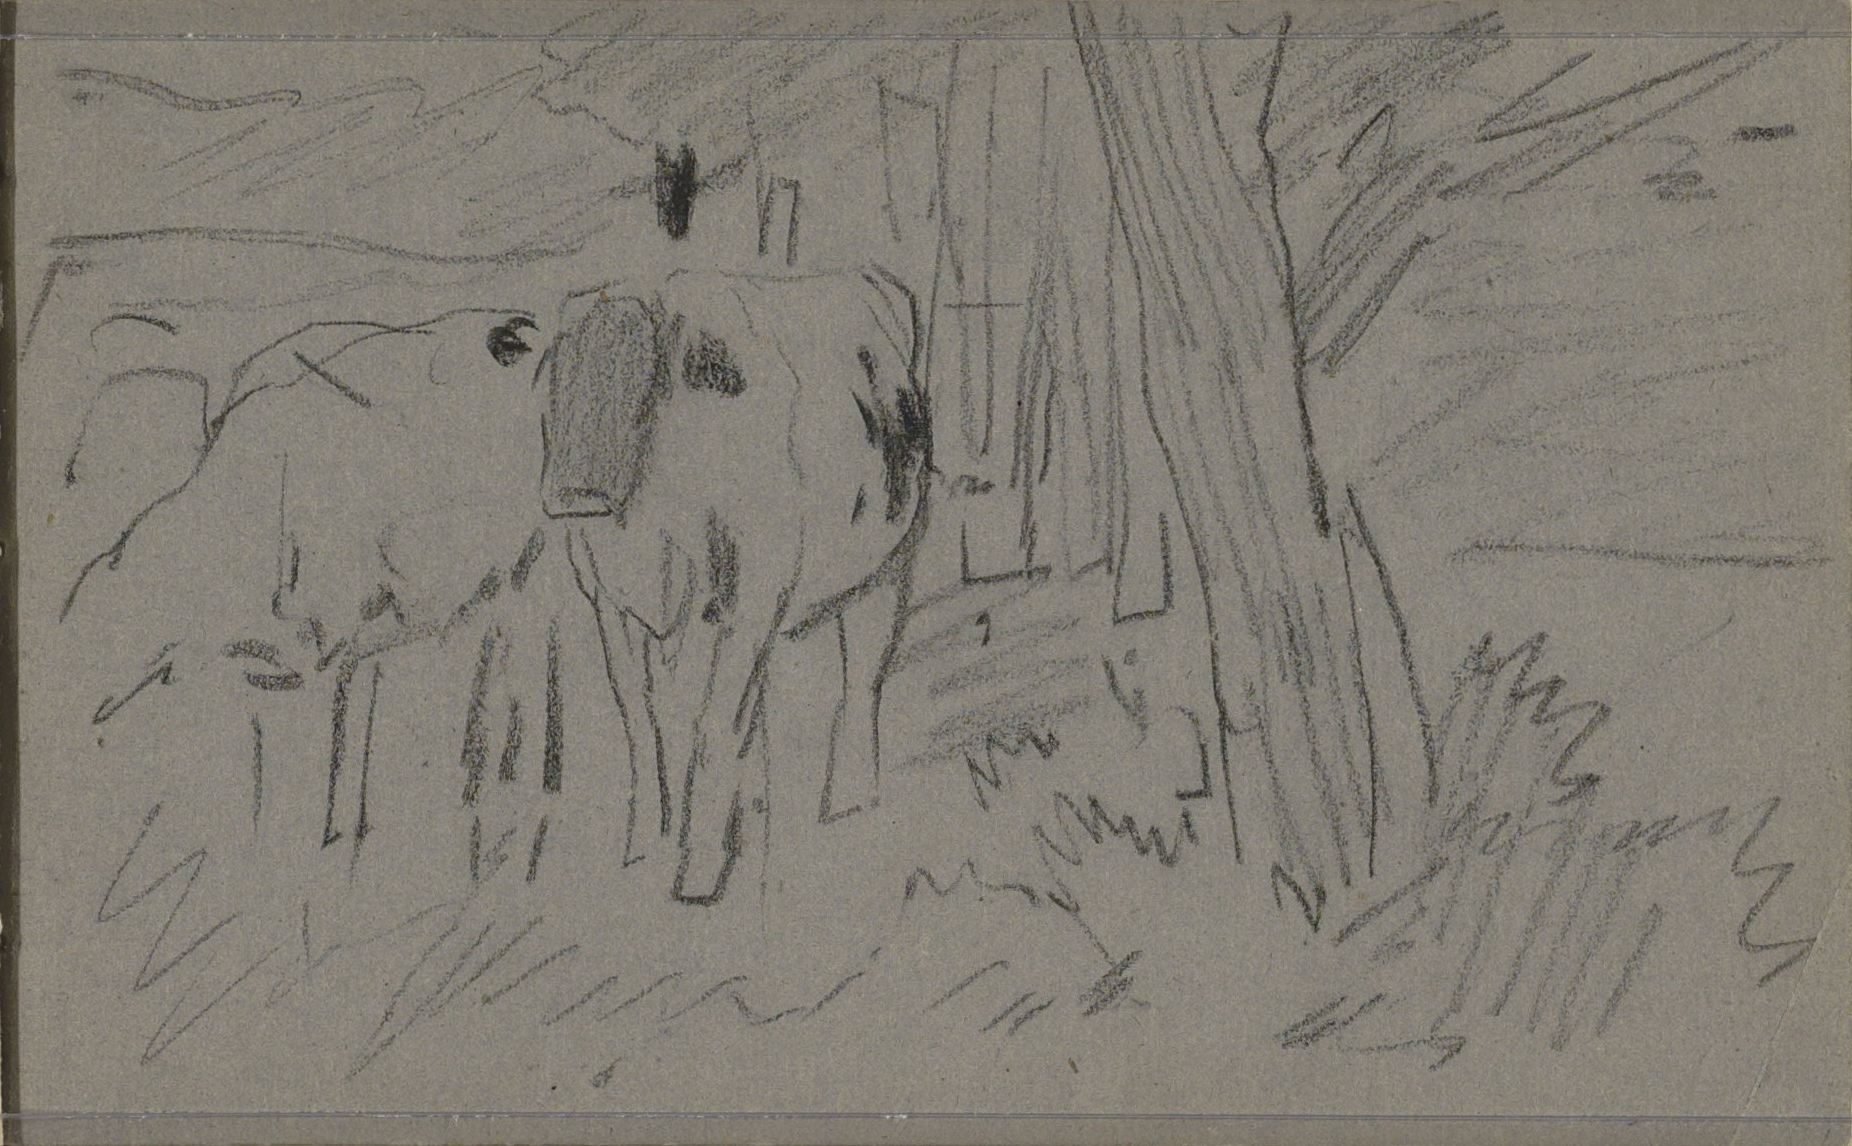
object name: sketchbook leaf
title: Koeien bij een rij bomen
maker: anton mauve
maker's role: draughtsman, painter, print maker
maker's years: 1838-1888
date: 1876-1888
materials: chalk, paper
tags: cow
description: Blad 17 recto uit een schetsboek met 34 bladen.